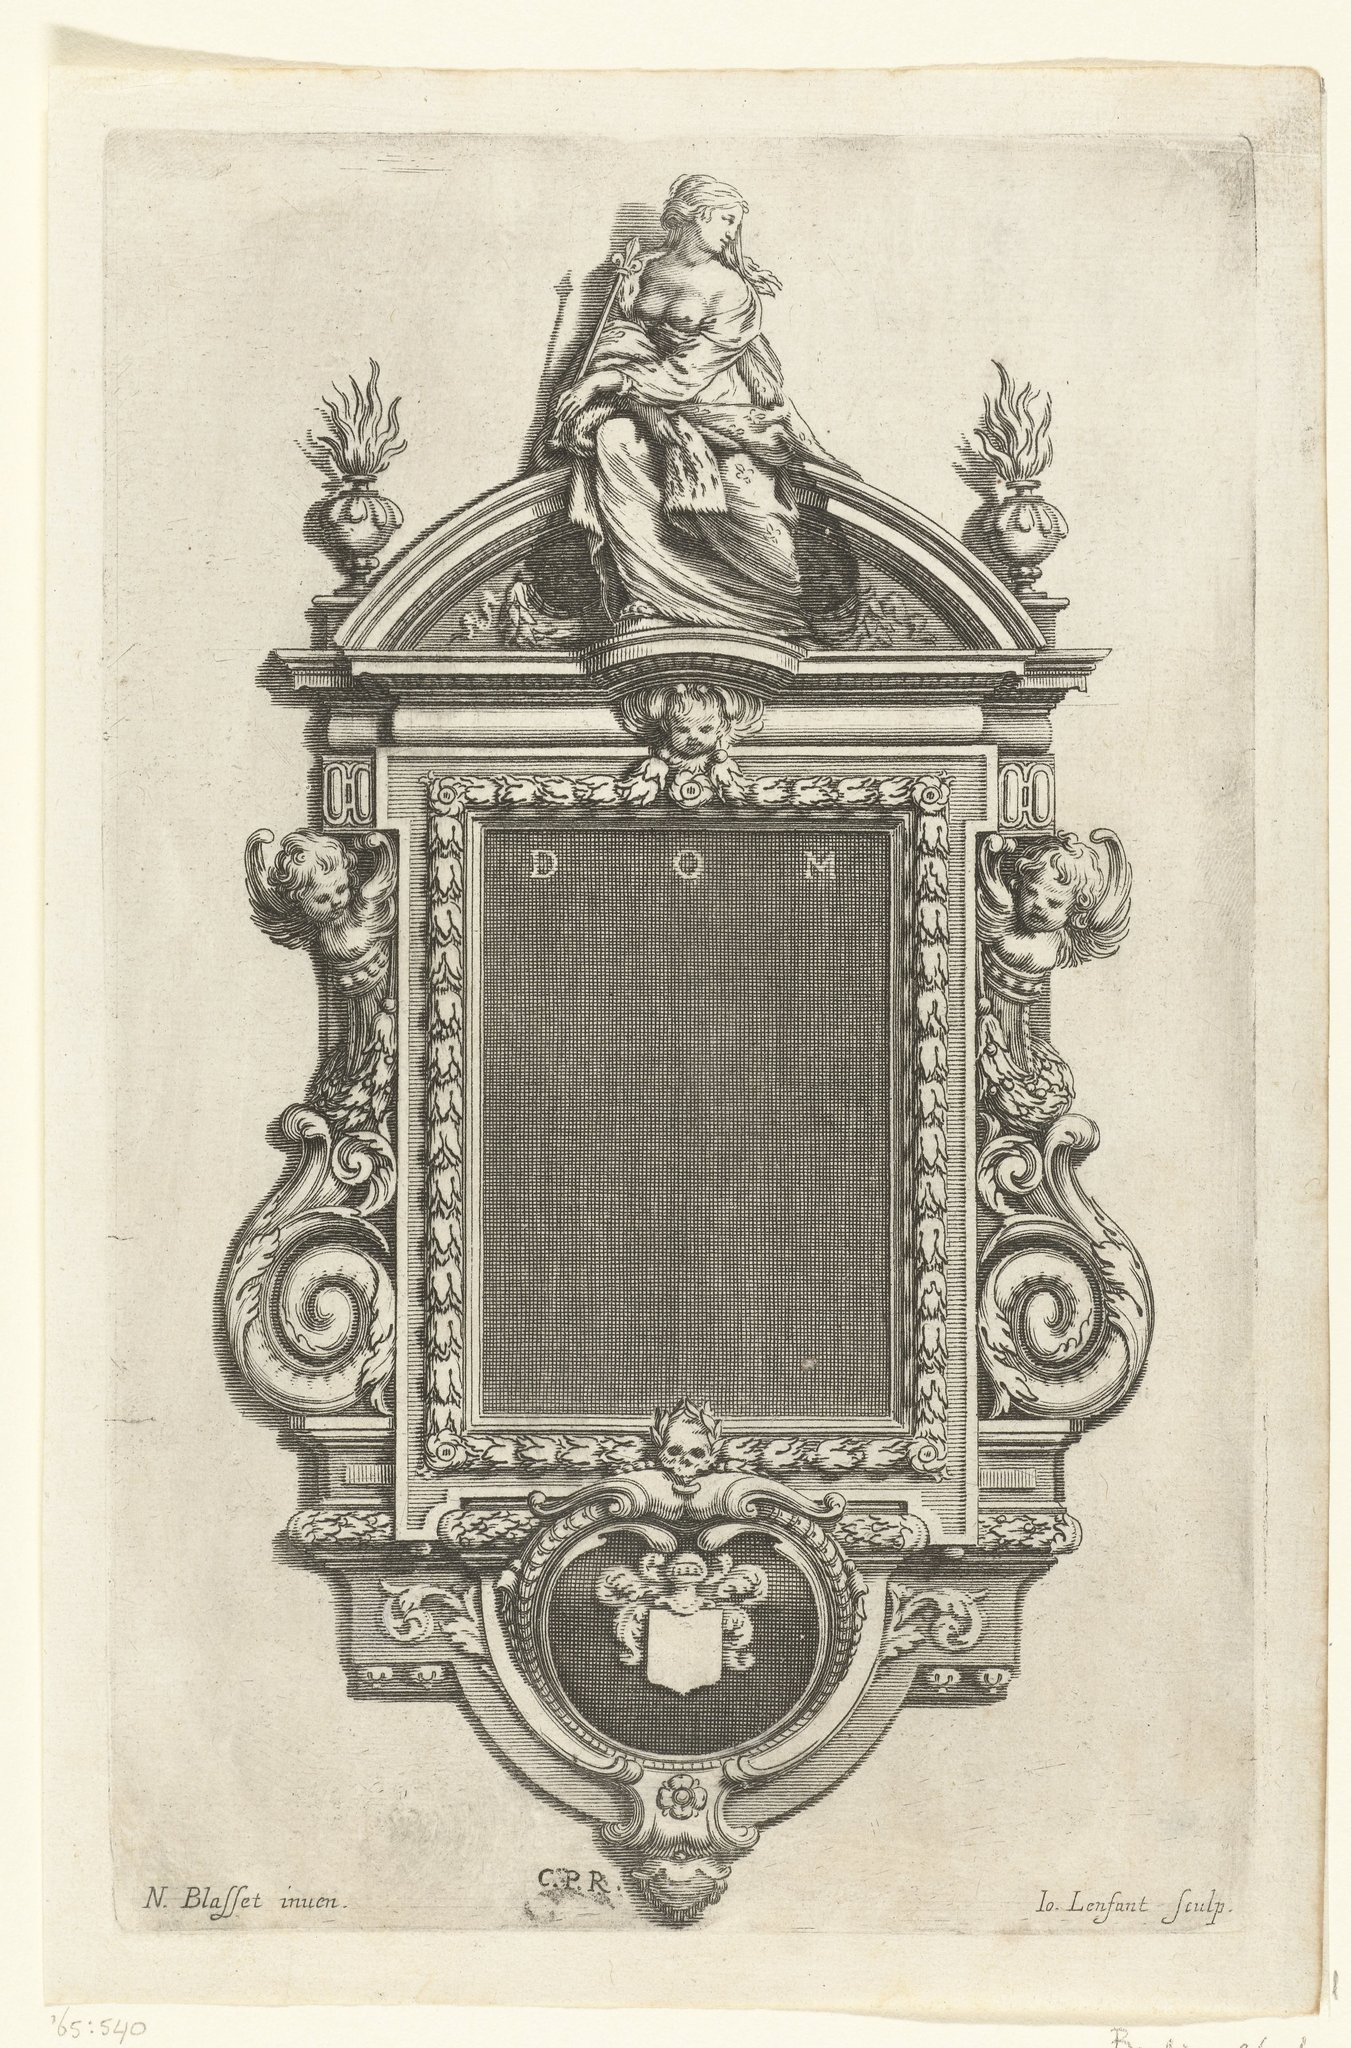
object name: ornament print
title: Les Epitaphes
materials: paper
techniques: engraving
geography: france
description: Rechthoekig veld met de letters DOM waarboven een vrouw zit met een scepter, bekroond met een fleur-de-lys. Uit serie van 7 bladen.